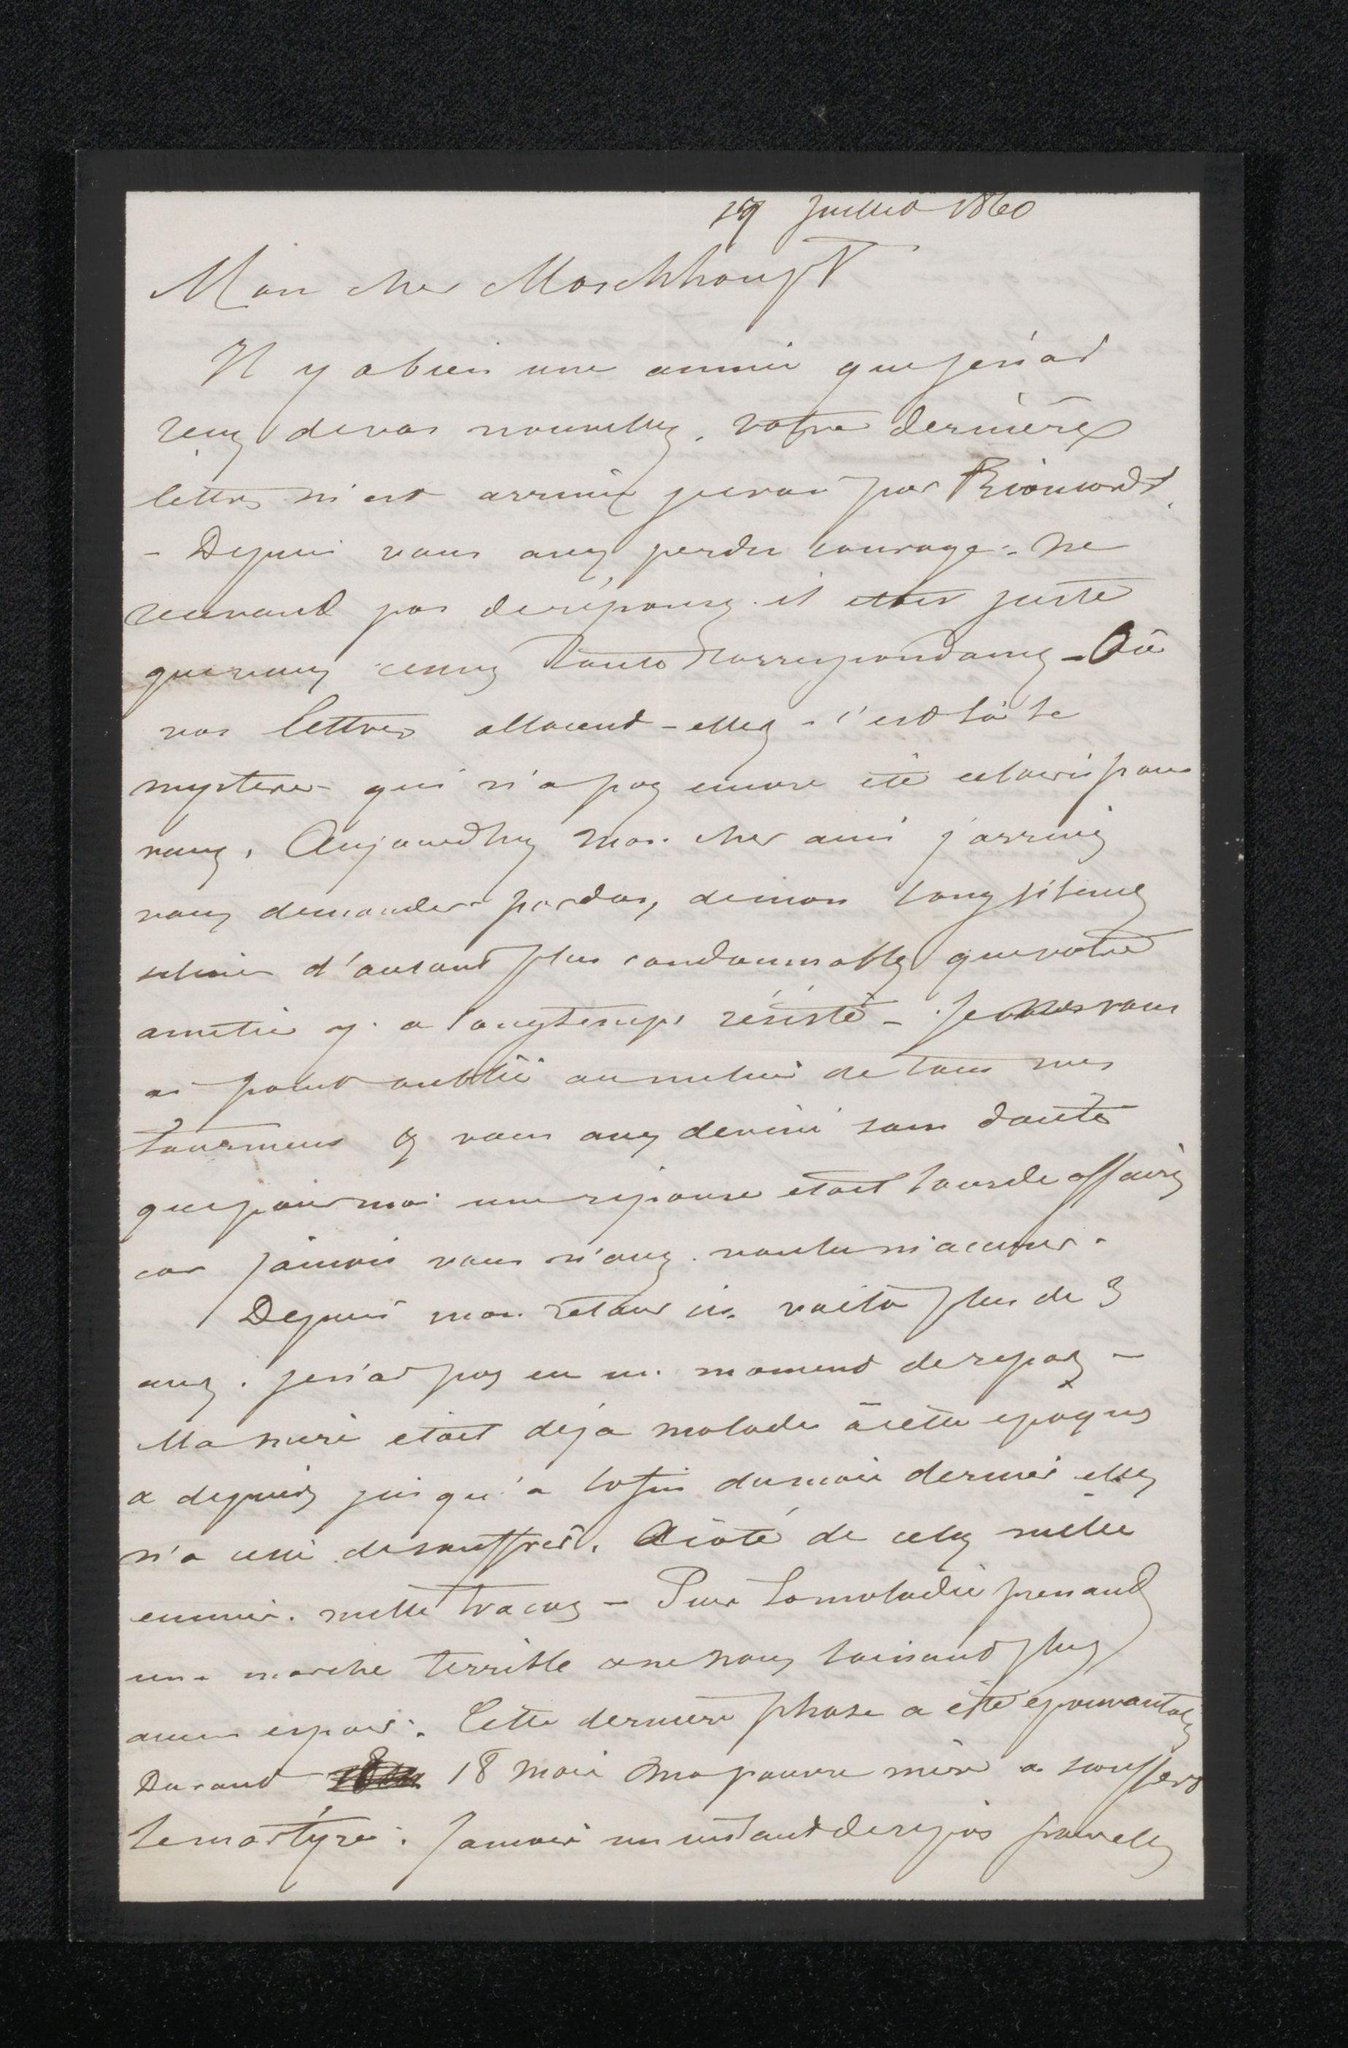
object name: letter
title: Brief aan Jan Hendrik Maschaupt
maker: adolphe mouilleron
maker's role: draughtsman, print maker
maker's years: 1820-1881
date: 1860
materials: ink, paper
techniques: pen, writing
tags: amsterdam, painter, jan hendrik maschaupt, family life, diseases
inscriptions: collector's mark: ‘RPK’